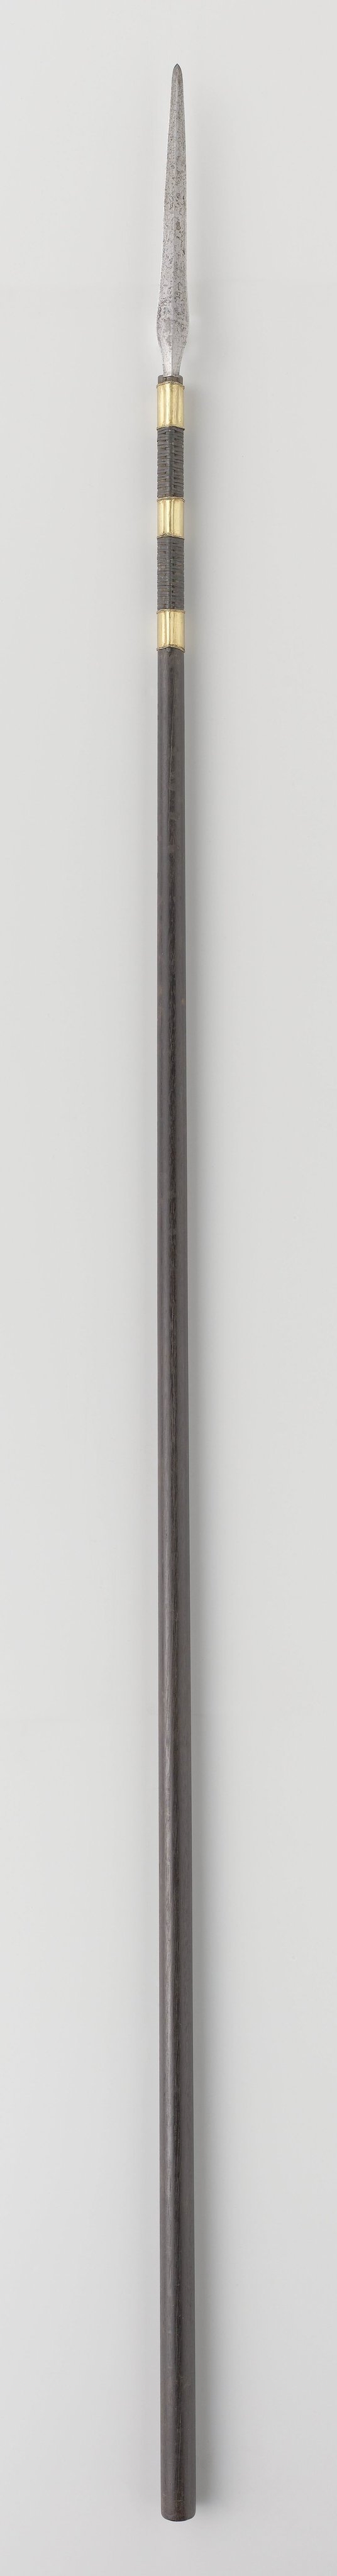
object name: pike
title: Lans van het wapenrek door Indische groten geschonken aan Gouverneur-Generaal J.C. baron Baud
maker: Anonymous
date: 1800-1900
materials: brass, iron, wood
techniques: cutting, forging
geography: java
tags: the hague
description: Ronde houten schacht die volledig hol is. Aan de bovenkant omwikkeld met 3.5 cm brede banden van messing (drie maal) afgewisseld met smalle ijzeren ringen. Deze banden verbinden de kling met de schacht. Smalle kling met scherpe punt, de basis toelopend in pin.